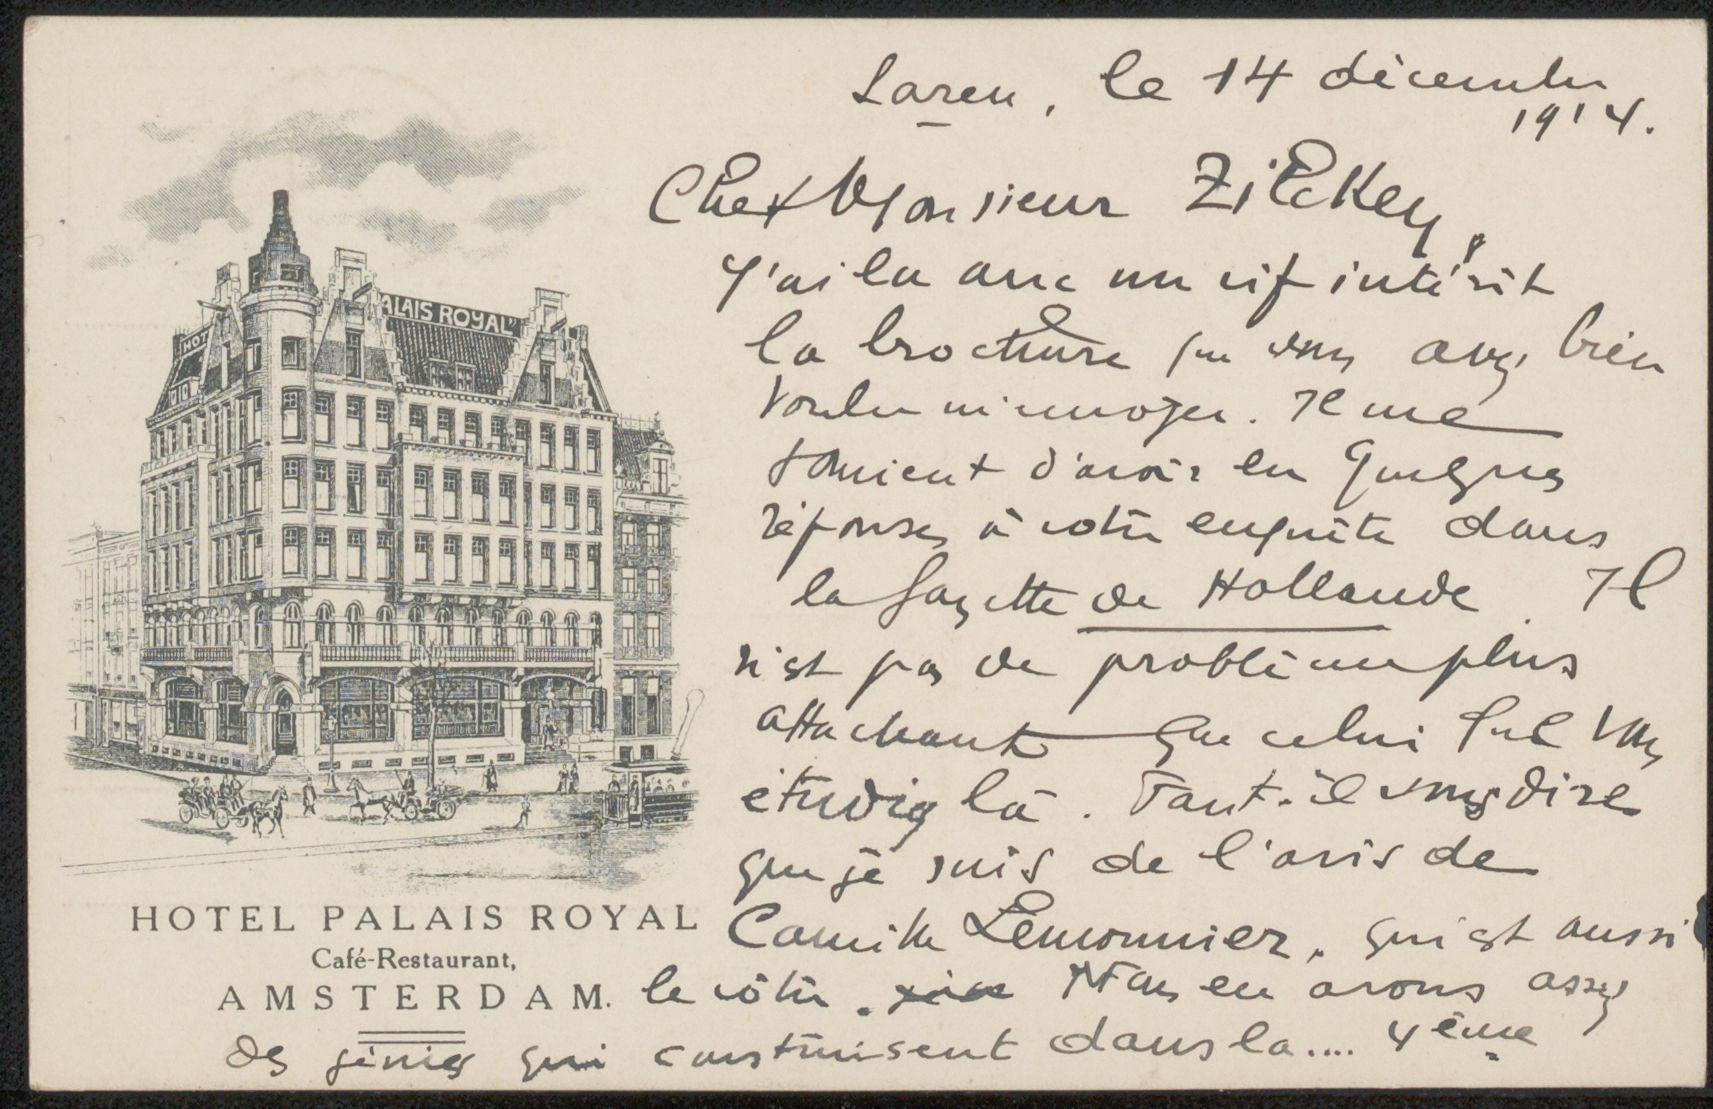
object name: postcard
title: Briefkaart aan Philip Zilcken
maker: louis piérard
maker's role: letterkundige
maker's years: 1886-1951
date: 1914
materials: cardboard, ink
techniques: pen, printing, writing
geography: laren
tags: camille lemonnier, the hague, draughtsman, philip zilcken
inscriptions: collector's mark: ‘RPK’